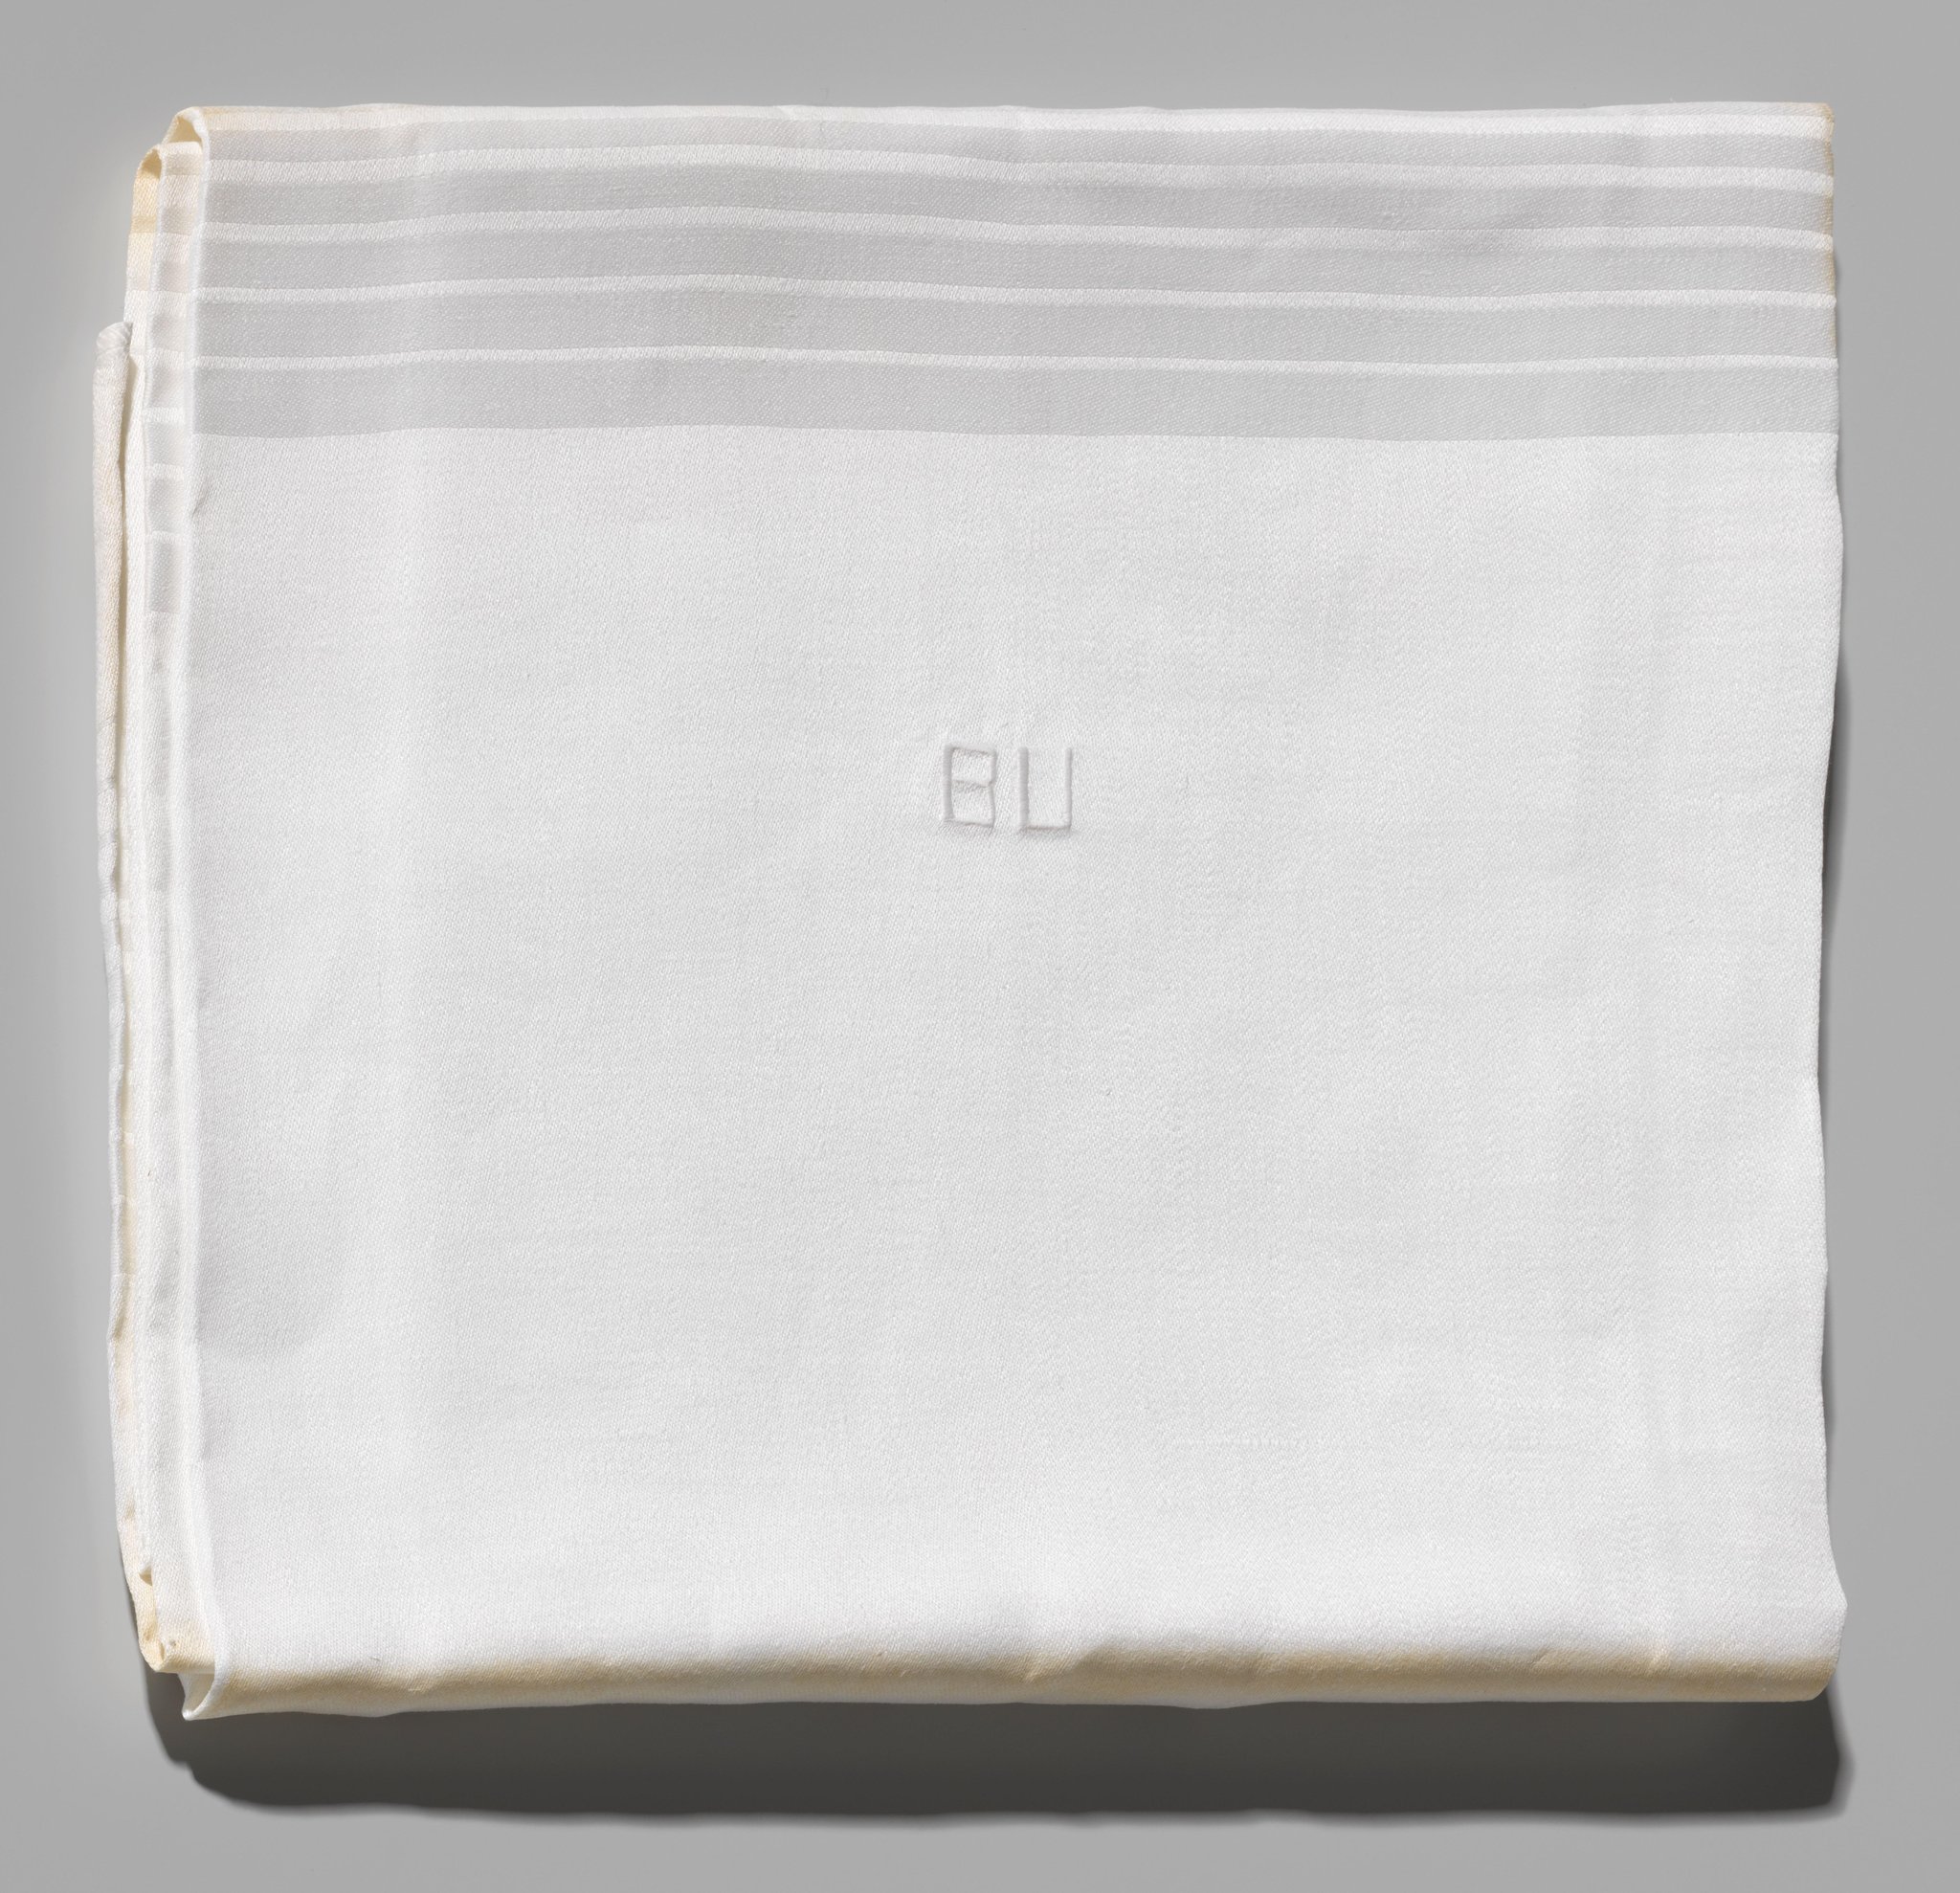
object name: tablecloth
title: Tafellaken met geometrisch patroon en de initialen BU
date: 1935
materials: linen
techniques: damask, embroidered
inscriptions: initials: ‘BU’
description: Tafellaken van wit linnendamast met ingeweven geometrisch patroon en de geborduurde initialen BU (Brusse-Urtebise).